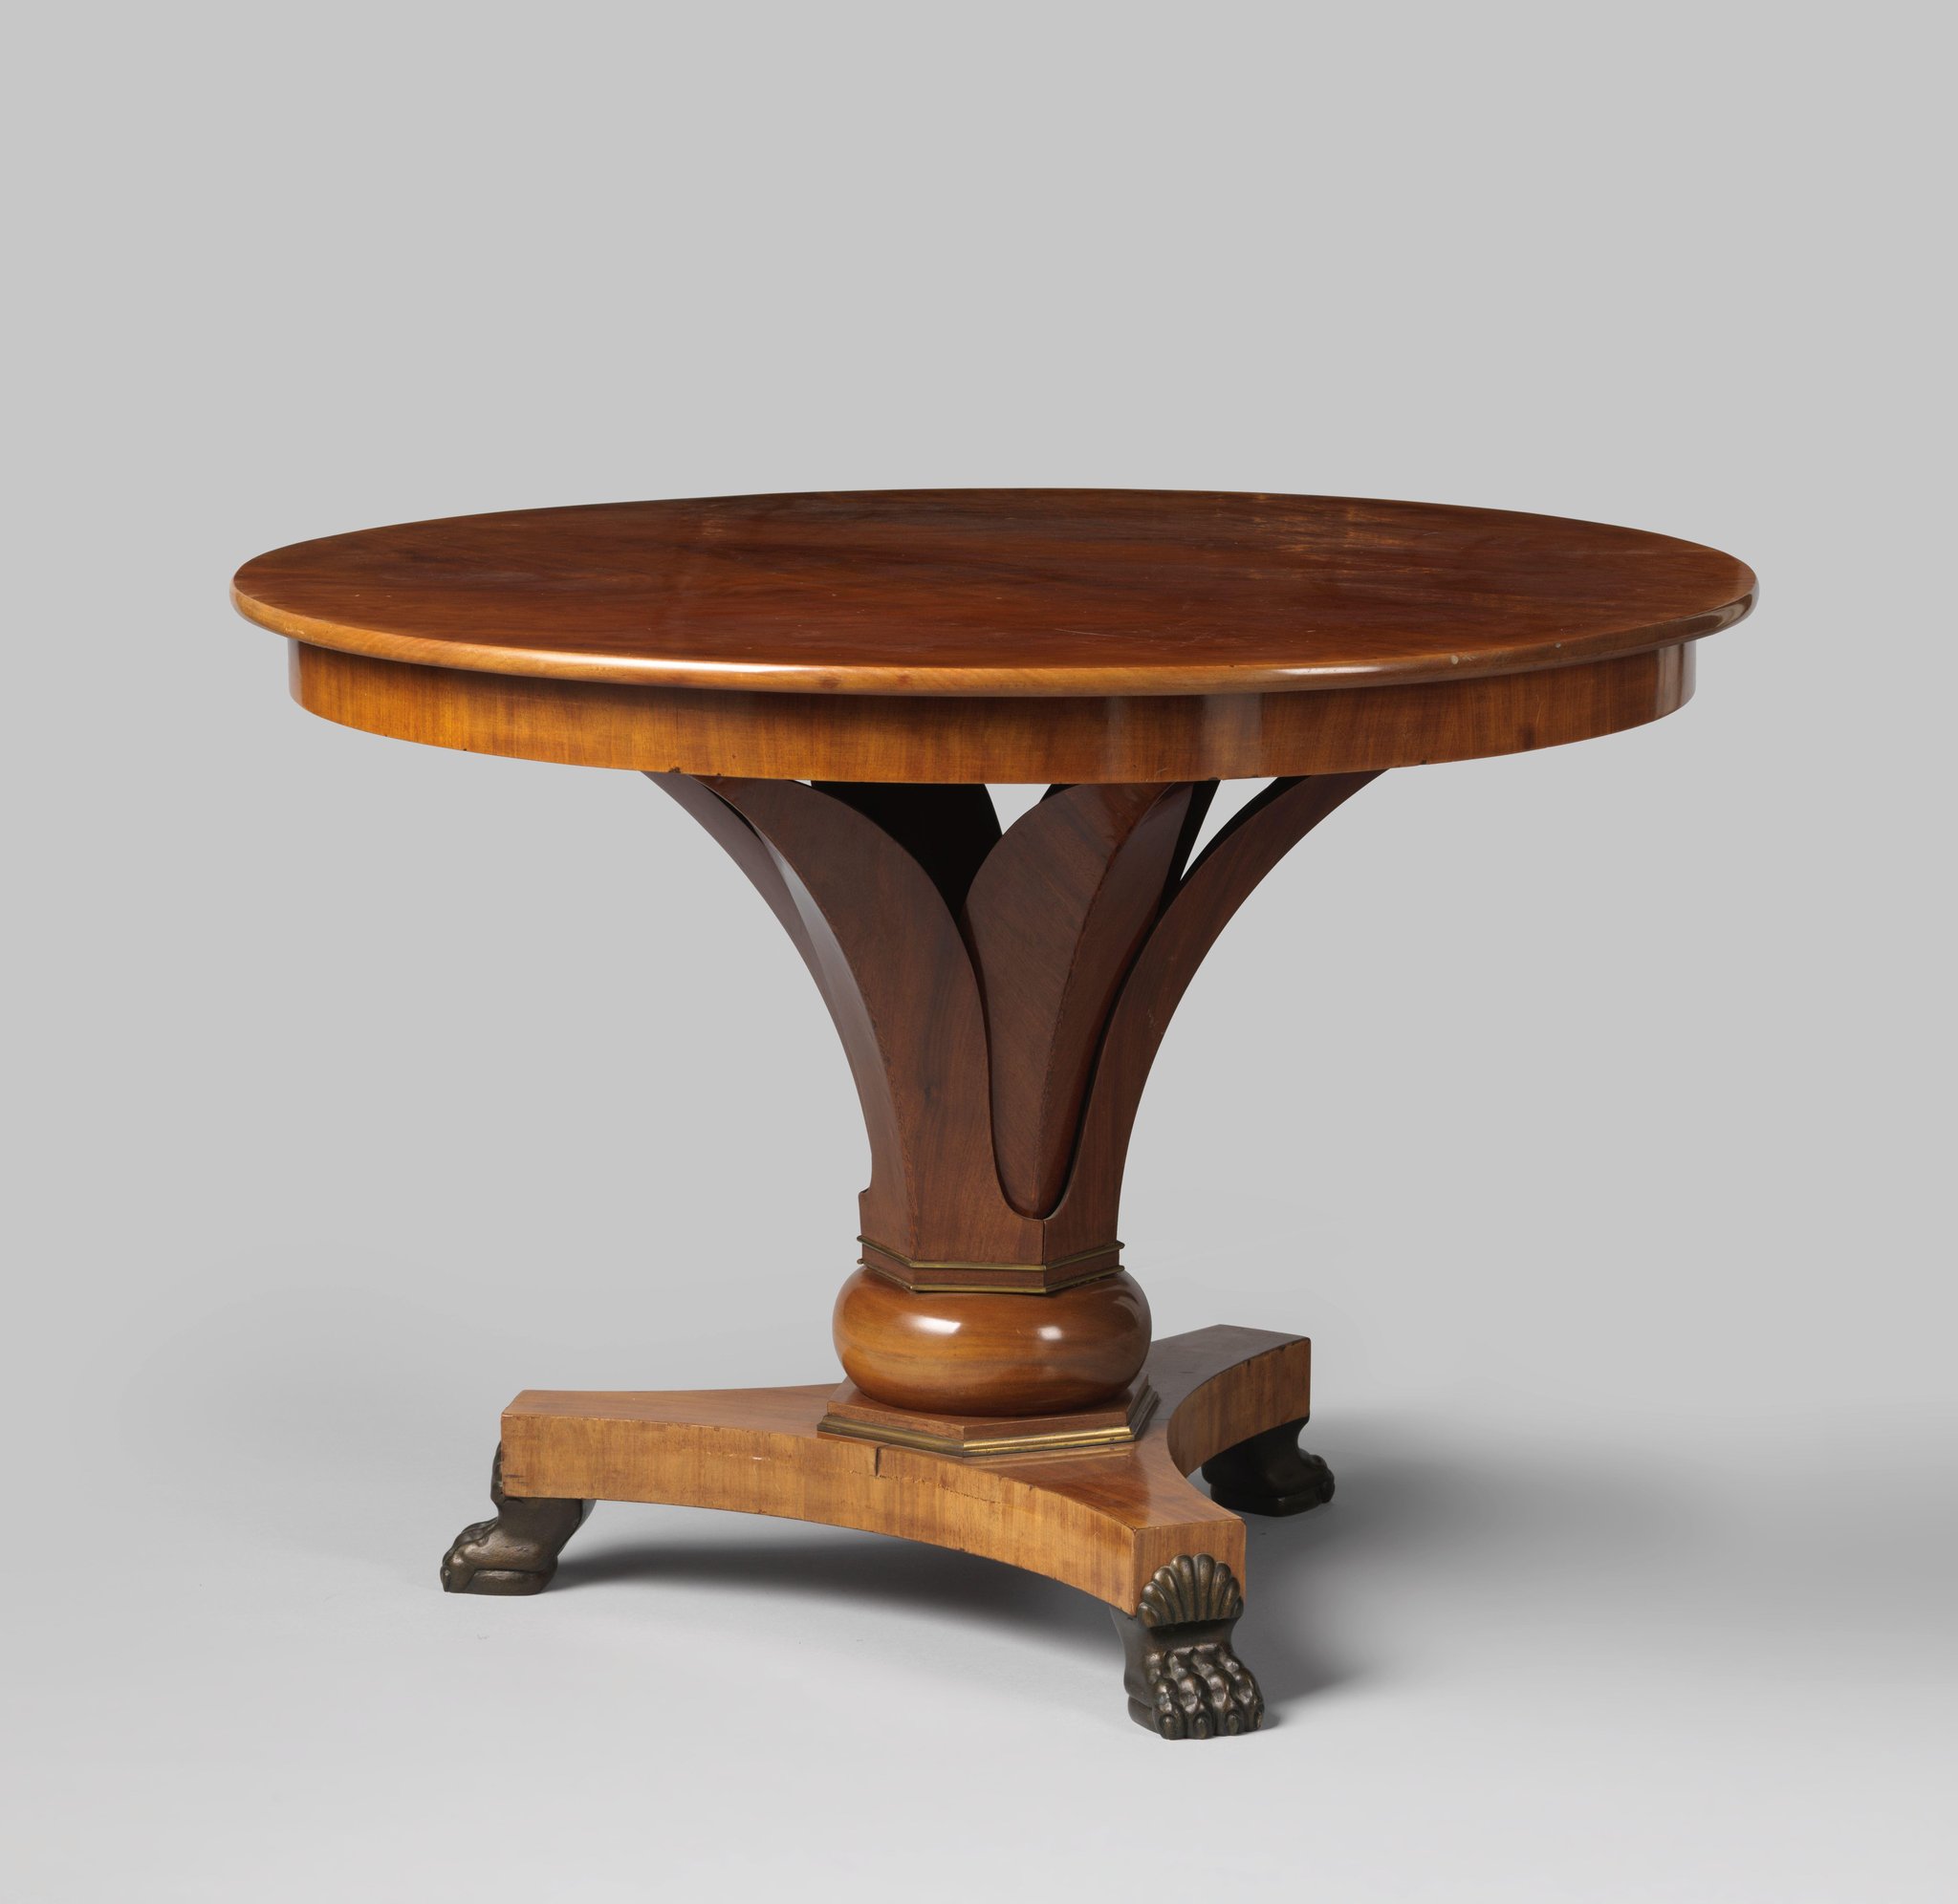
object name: furniture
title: Tafel, rond, van mahoniehout, rustend op een zeshoekige, onderaan van bronzen profielen voorziene voet bestaande uit een kelk van zes lancetvormige bladeren. Geheel rust op een driehoekig voetstuk met concave zijden, op klauwpoten.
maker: Anonymous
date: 1800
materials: brass, bronze, wood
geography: northern netherlands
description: Ronde tafel van mahoniehout rustend op een zeshoekige, onderaan van bronzen profielen voorziene, voet bestaande uit een kelk van zes lancetvormige bladeren. Deze voet rust weer op een driehoekig voetstuk met concave zijden op klauwpoten. Boven deze poten is een schelpvormige versiering aangebracht. Een verwante, maar rijker uitgevoerde tafel is in 1817 geleverd door Pieter Paulus Horrix aan de Koningin.